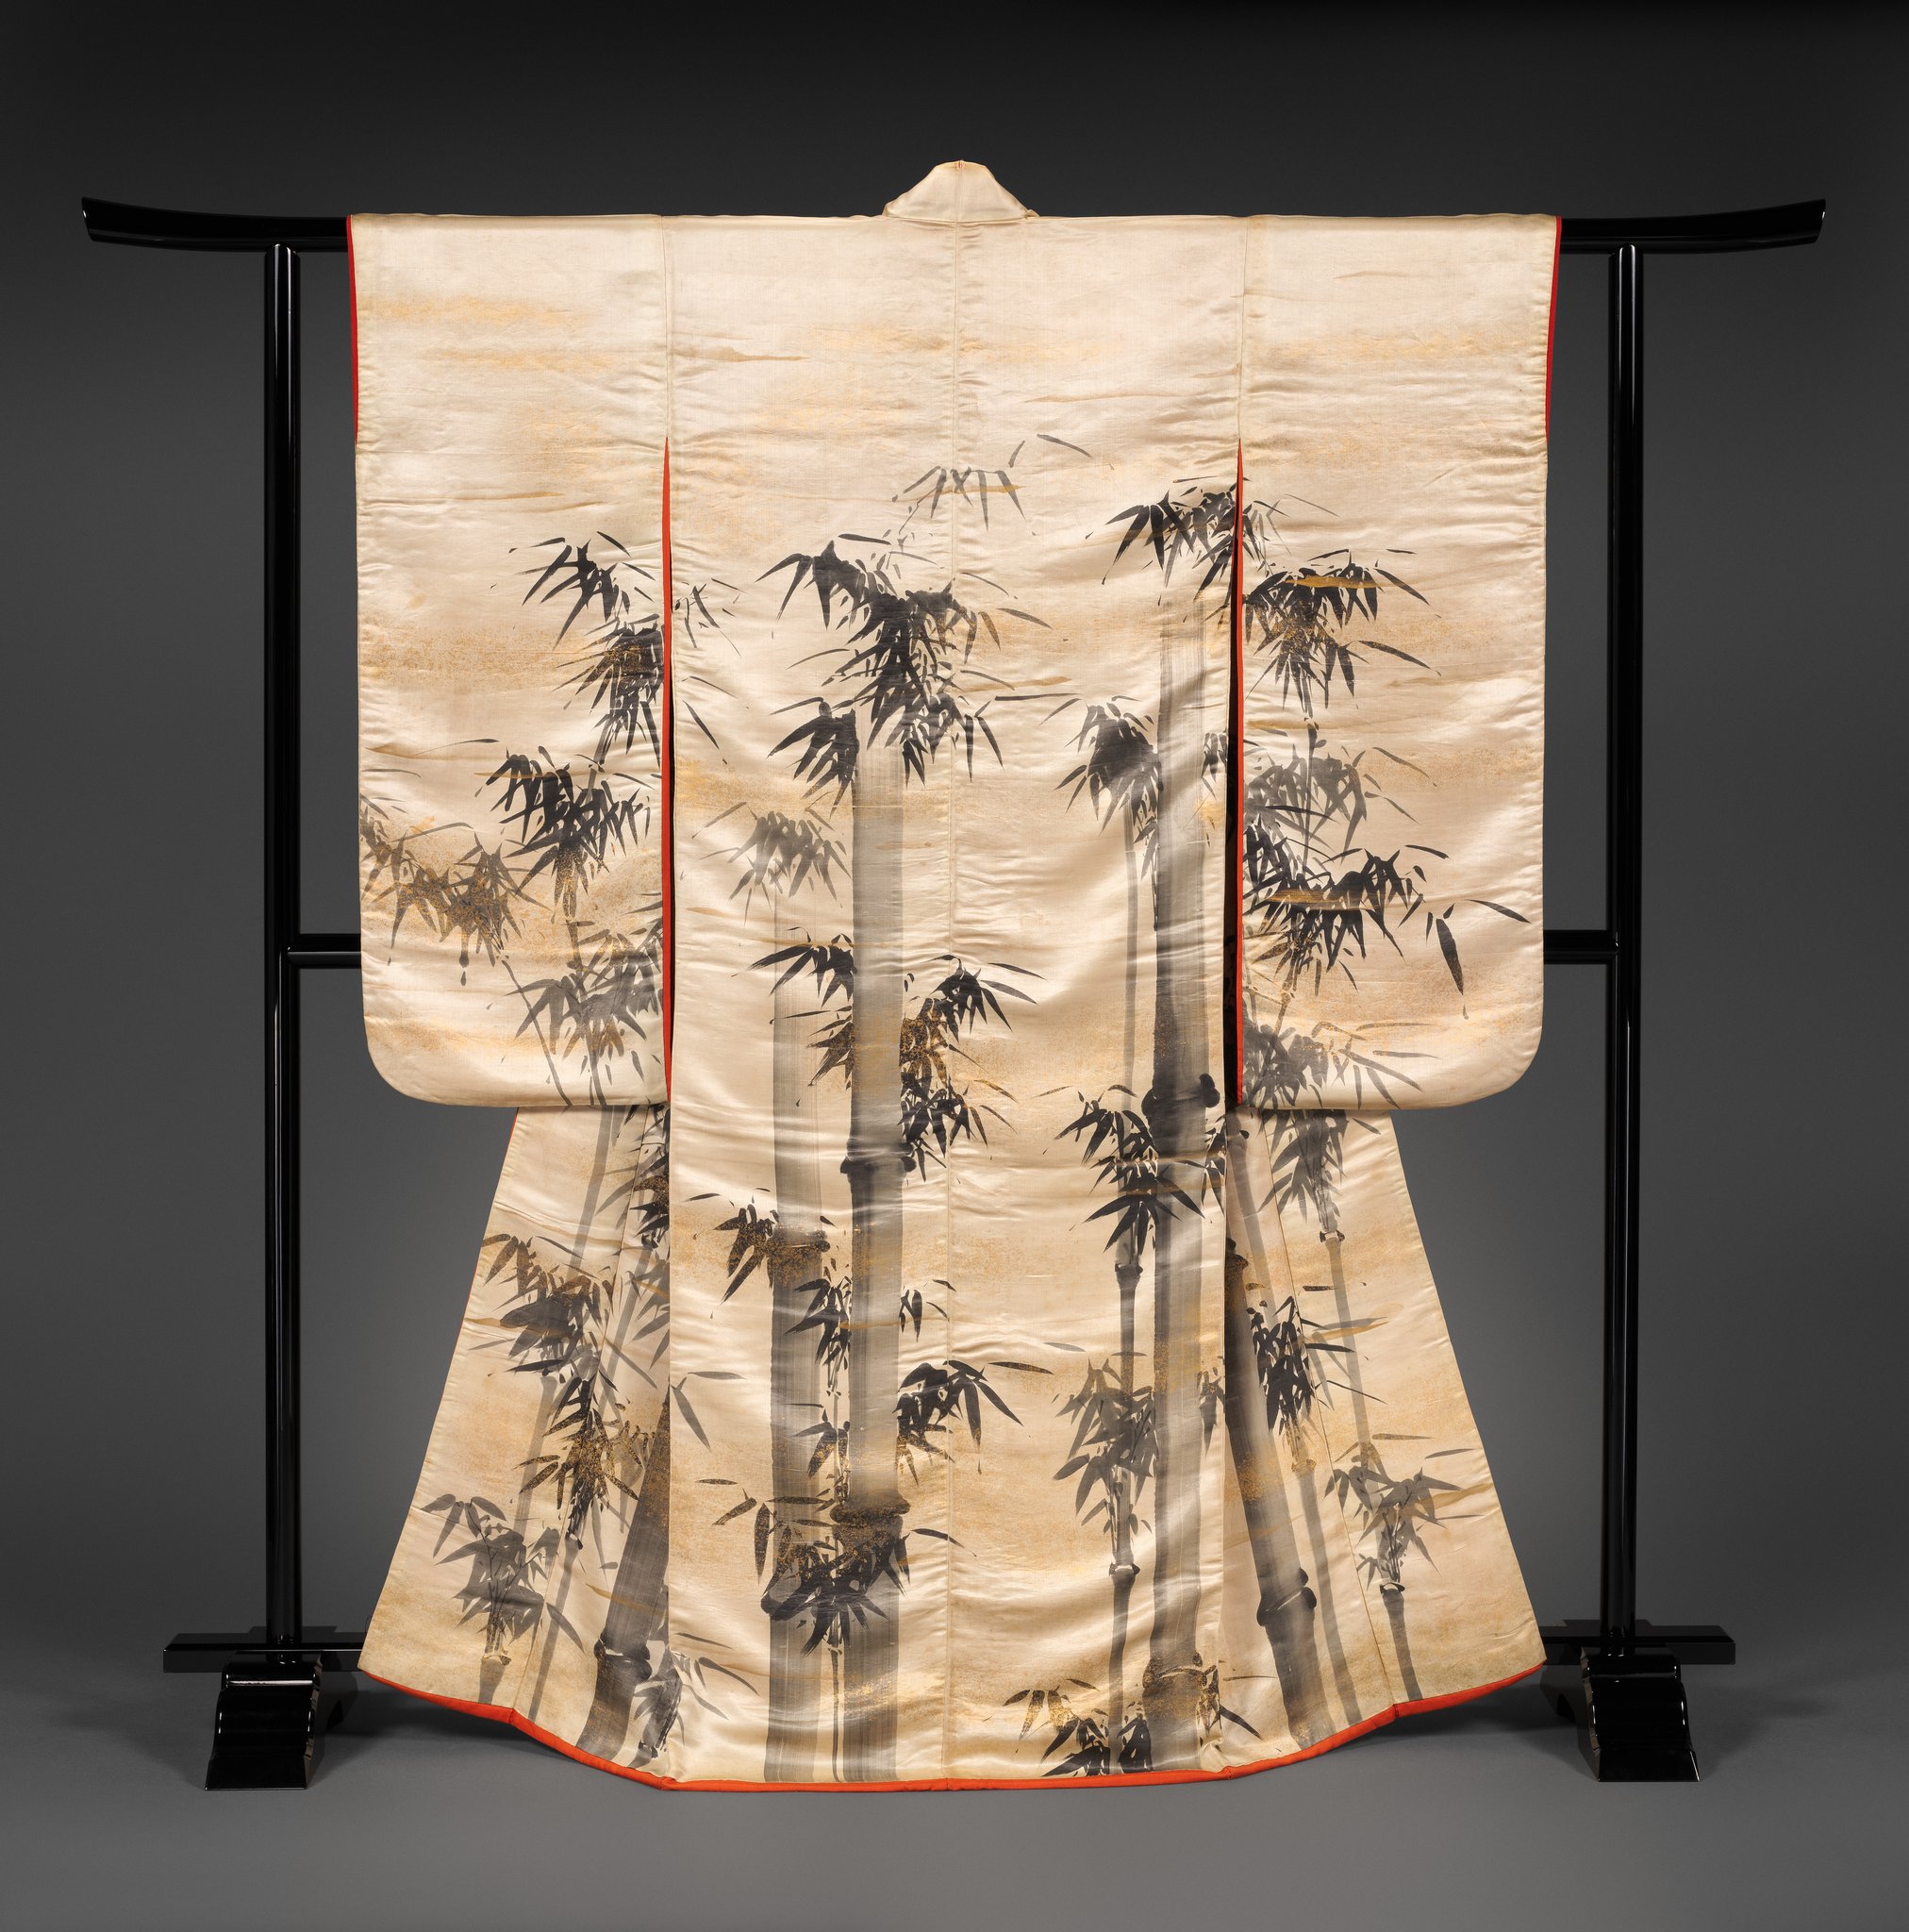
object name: over robe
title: Over Robe (Uchikake) with Bamboo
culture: japanese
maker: gion nankai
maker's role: artist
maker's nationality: japanese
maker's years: 1677-1751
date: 1701-1750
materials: gold, ink, silk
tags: bamboo